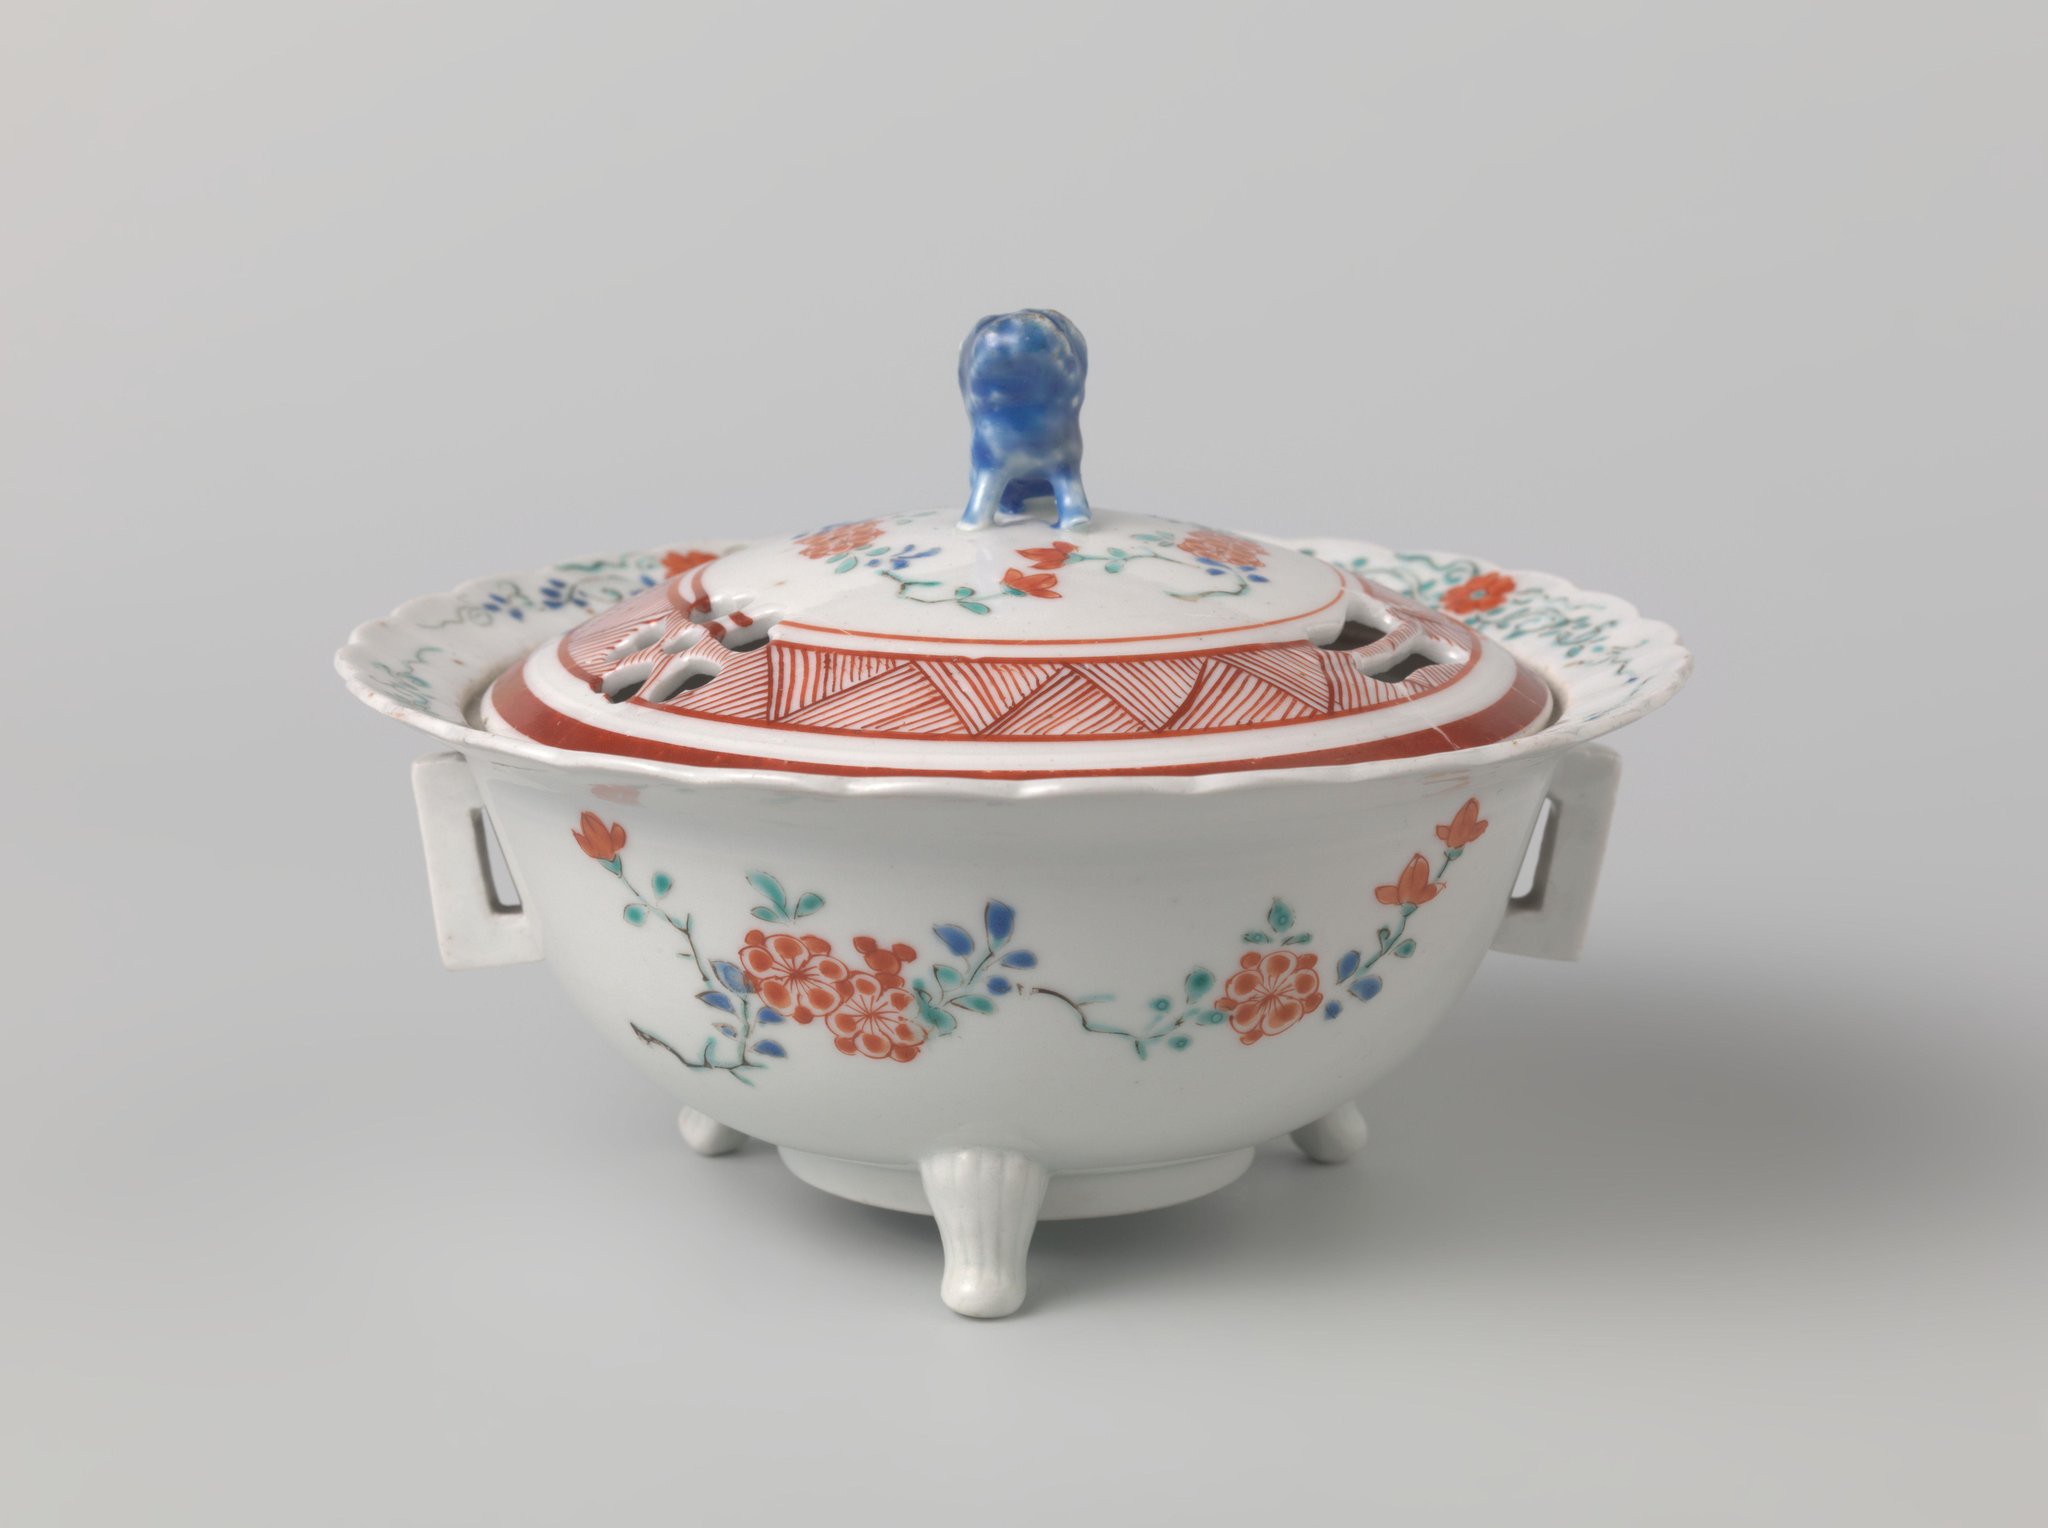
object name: incense burner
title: Incense burner with lid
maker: Anonymous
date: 1670-1690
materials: glaze, paint, porcelain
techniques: firing, turning, vitrification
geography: arita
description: Bolle deksel van wierookbrander bekroond met een shishi (leeuwhond) met openingen in de vorm van een waaier, een kersenbloesem en een enkel kersenbloesemblad. Beschilderd op het glazuur in blauw, rood groen en zwart met prunustakken en een rand van driehoeken met lijnen op de deksel. Deksel is gerestaureerd. Kakiemon.